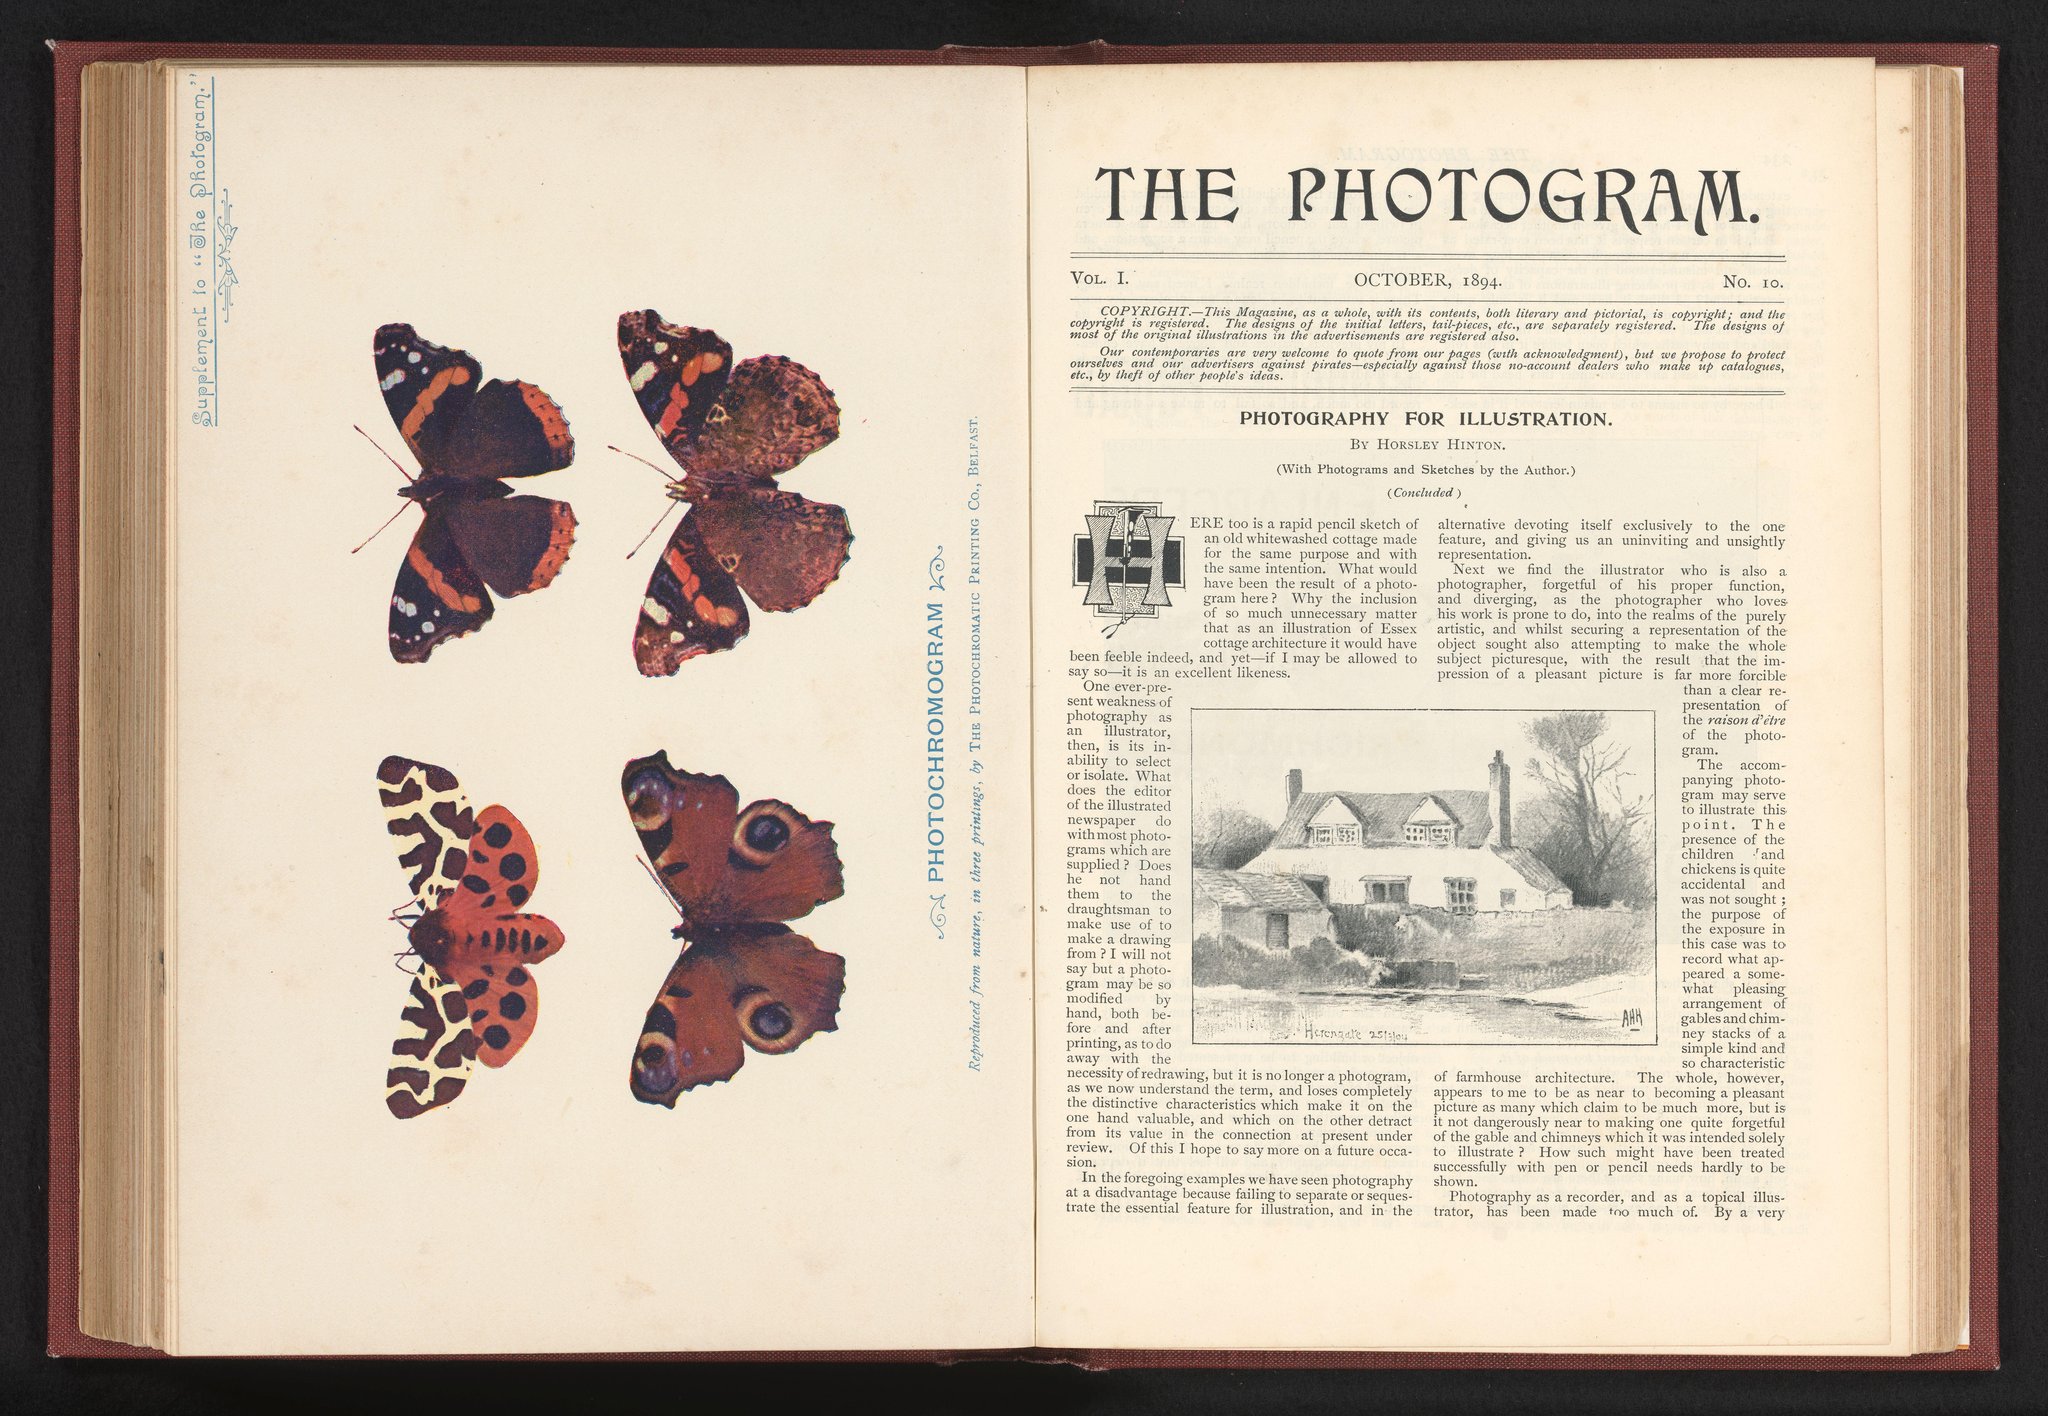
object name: photomechanical print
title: Vier vlinders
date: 1889-1894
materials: paper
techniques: three-color autotype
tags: insects: butterfly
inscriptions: inscription: ‘Photochromogram/ reproduced from nature in three printings’